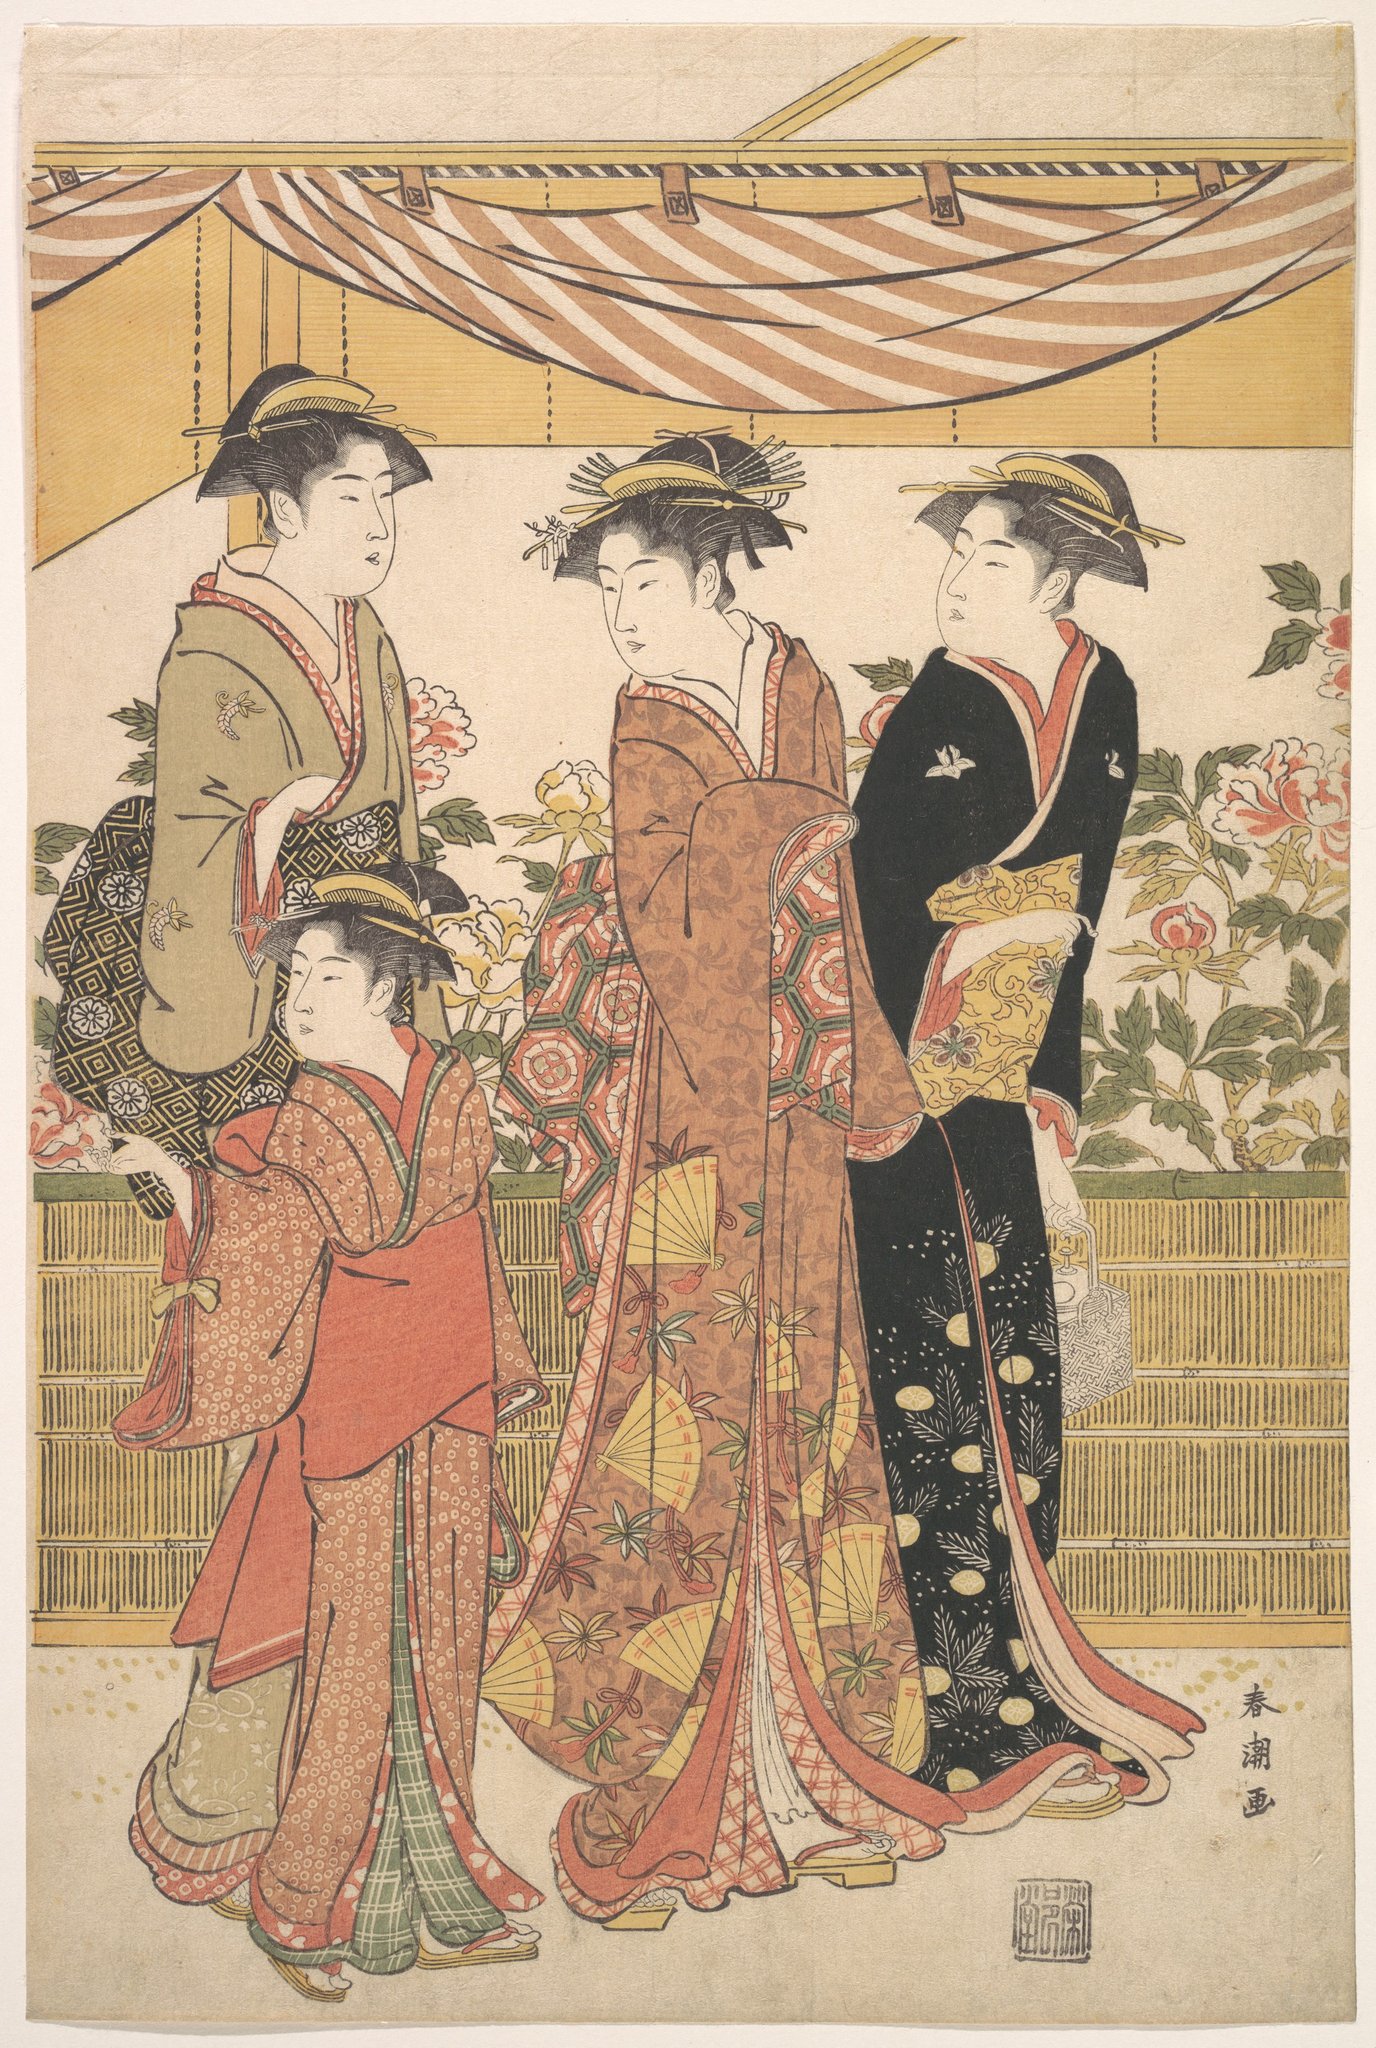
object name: print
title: The Bōtan Show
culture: japanese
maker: katsukawa shunchō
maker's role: artist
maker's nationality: japanese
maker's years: 1775-1795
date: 1790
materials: ink, paper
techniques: woodblock print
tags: girls,women,flowers